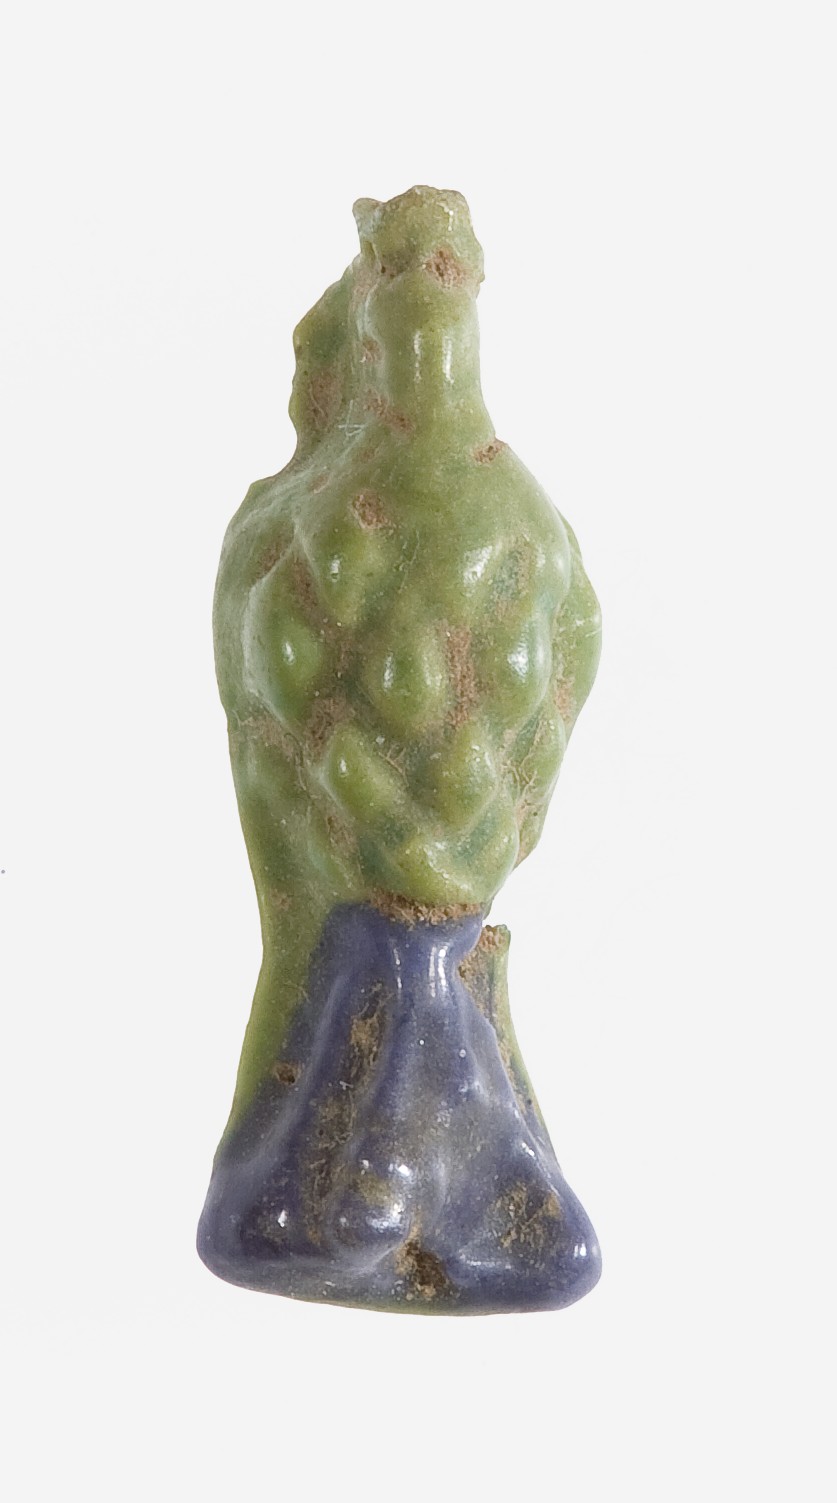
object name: pendant, cornflower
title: Cornflower Pendant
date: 1390-1352 BCE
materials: faience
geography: egypt